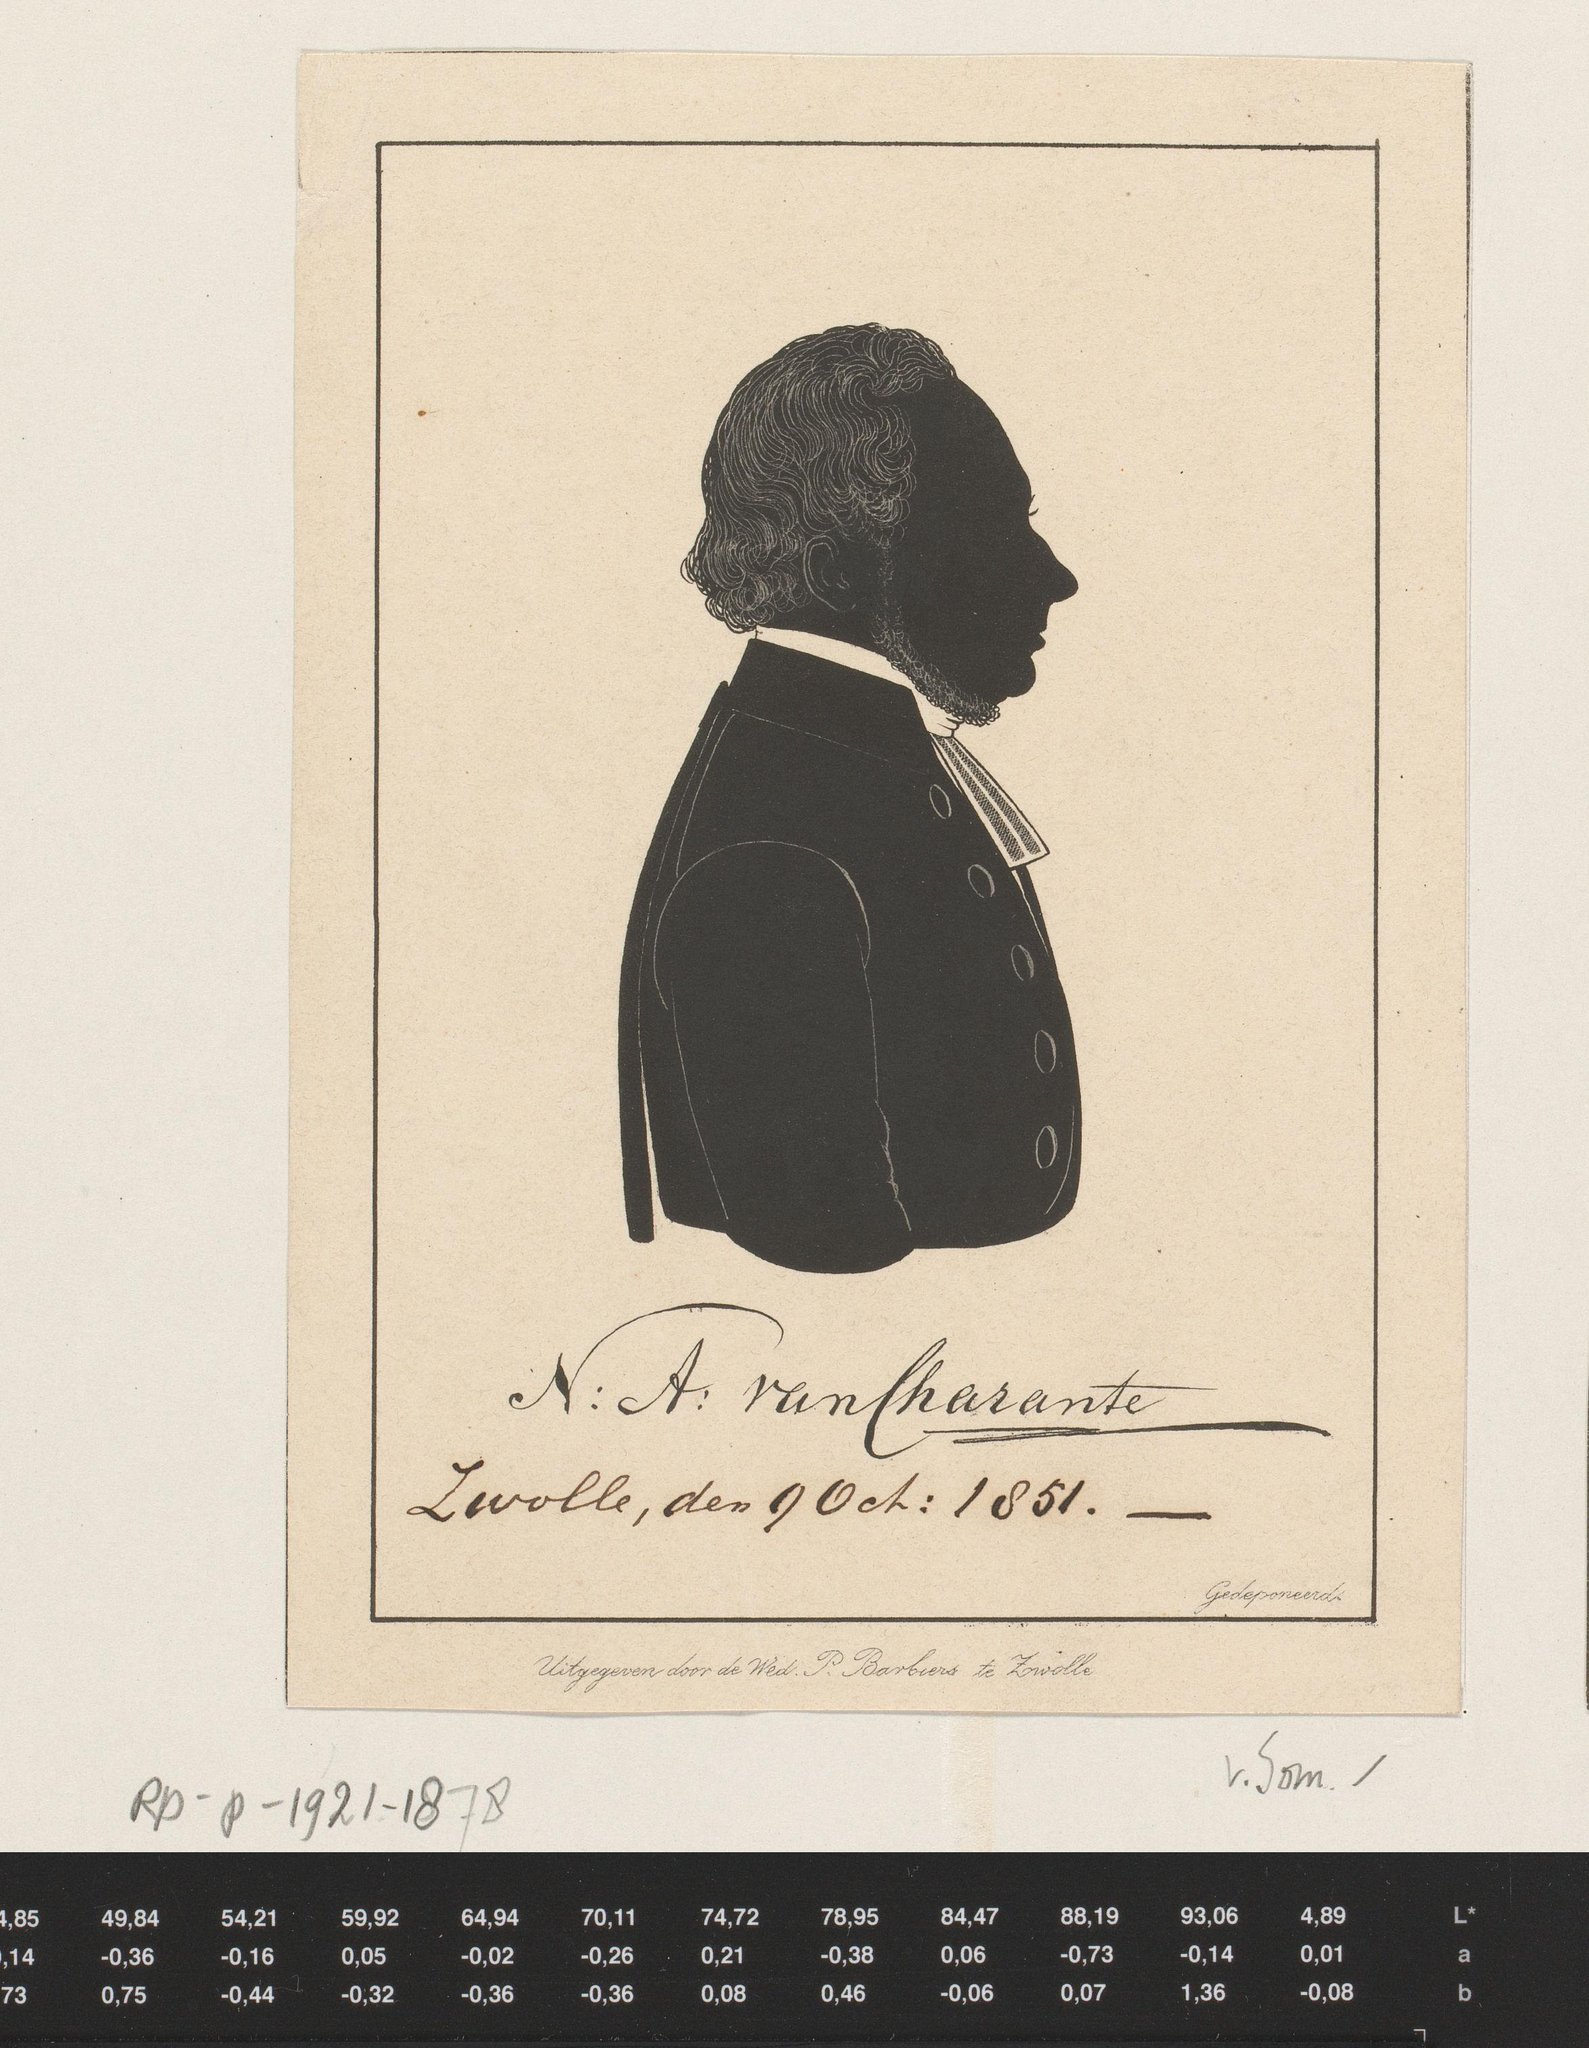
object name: print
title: Silhouetportret van Nicolaas Antonie van Charante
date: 1851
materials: paper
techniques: hand coloring, lithograph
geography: zwolle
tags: historical persons, writer, poet, author, functionaries and dignitaries ~ protestant churches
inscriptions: : ‘Gedeponeerd.’, collector's mark: Lugt 2233, date: ‘Zwolle, den 9 Oct: 1851. -’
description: Met facsimile handtekening van de geportretteerde.